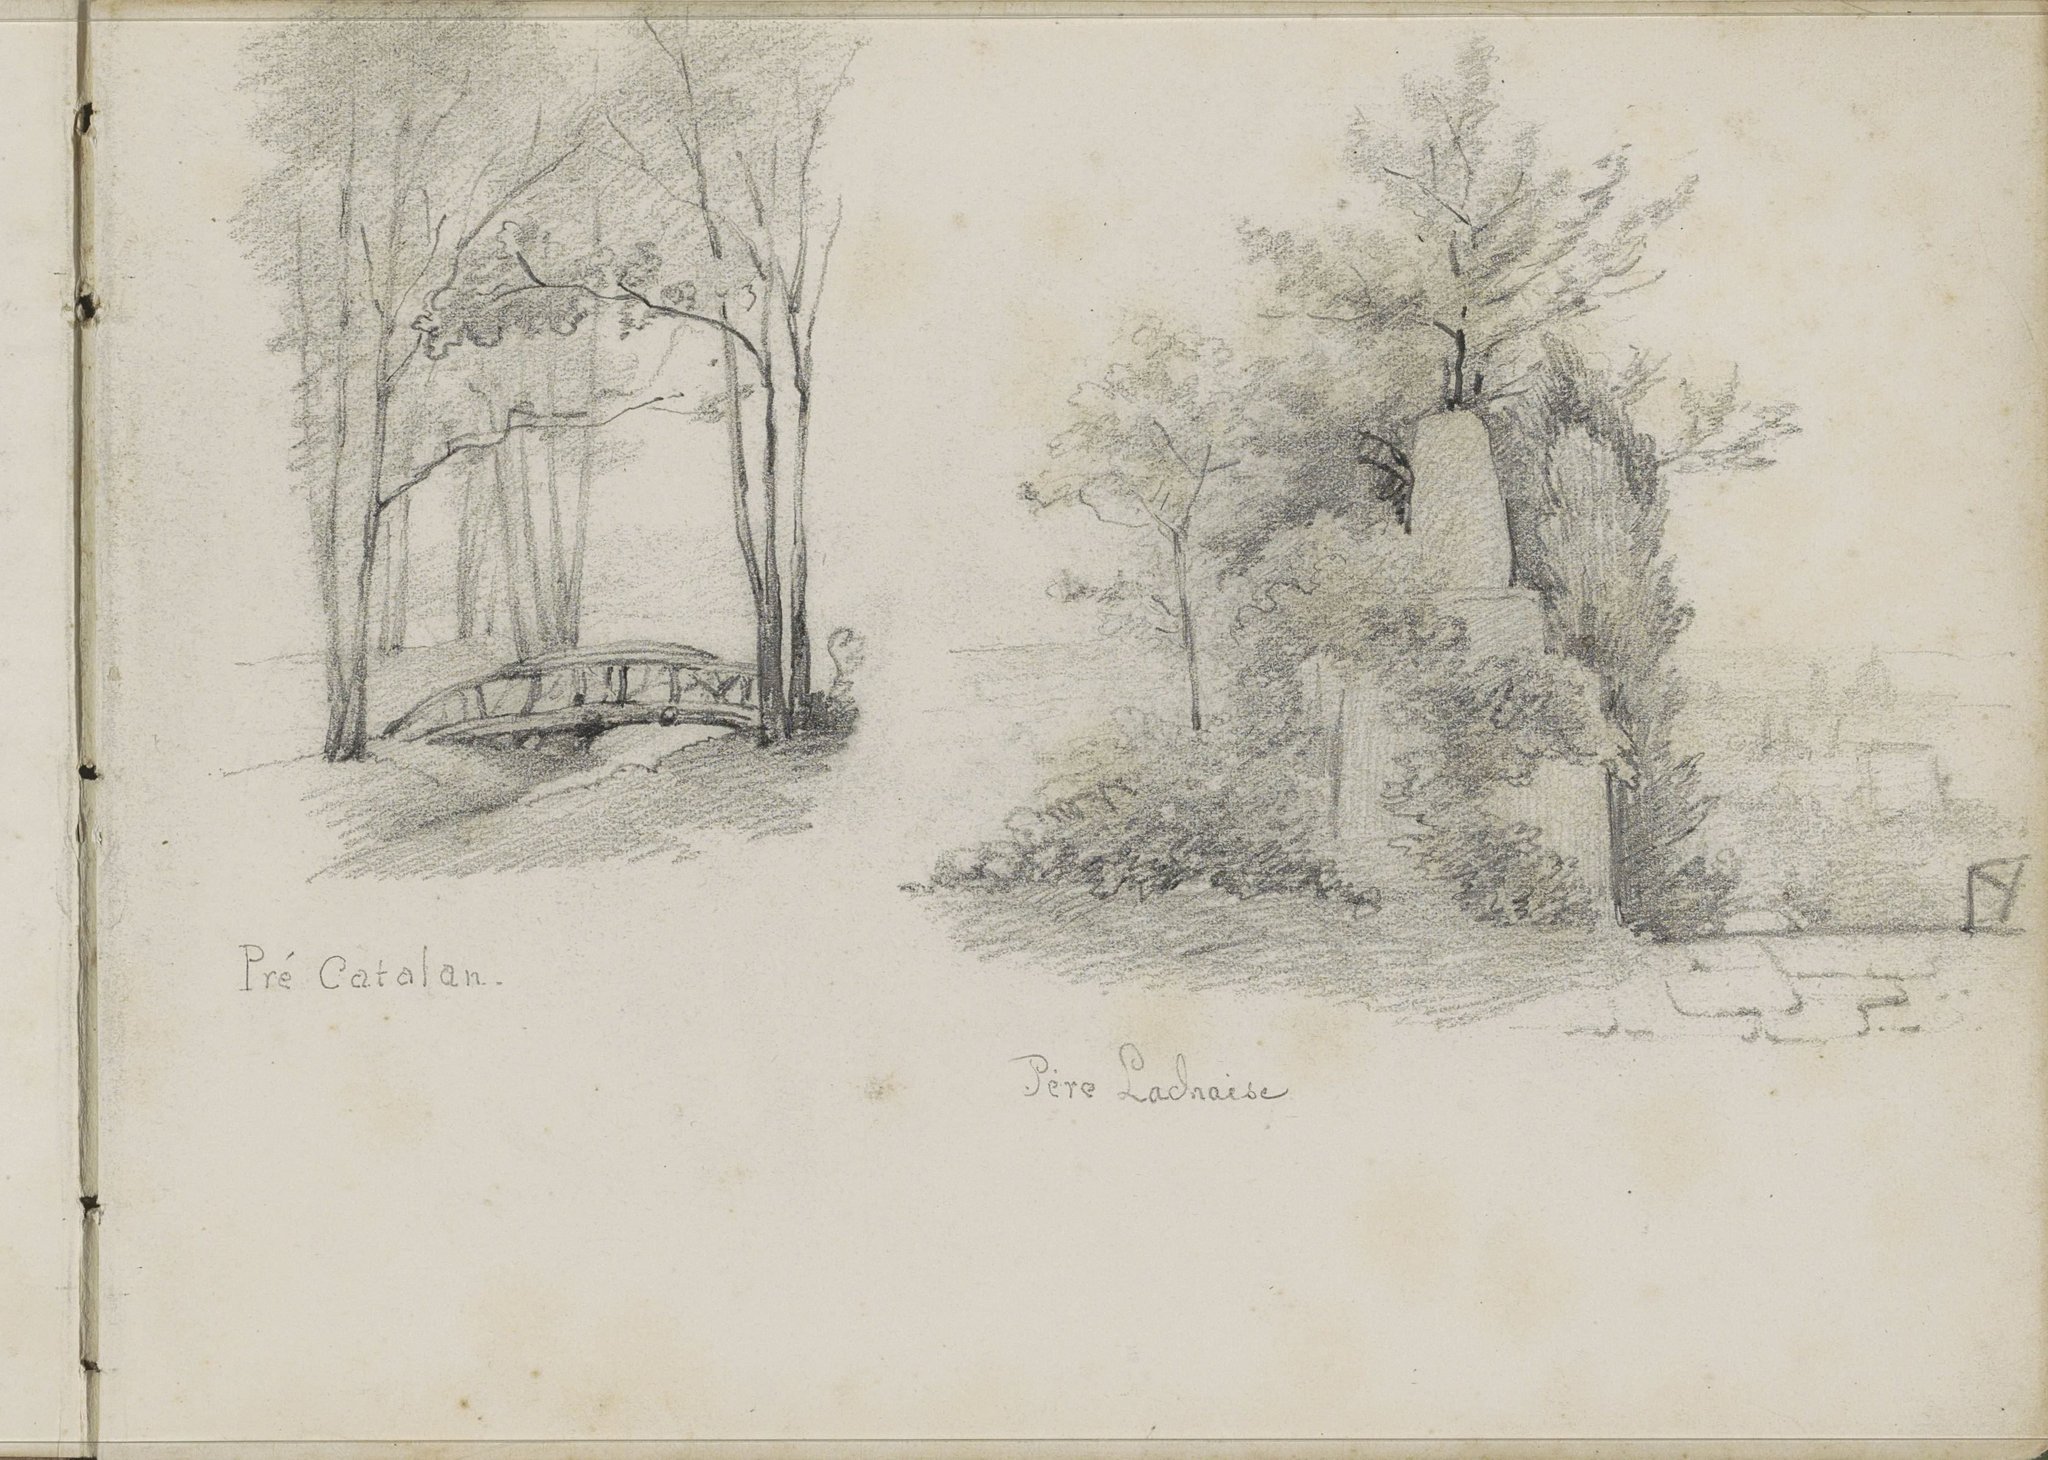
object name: sketchbook leaf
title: Brug bij Pré Catalan en een monument op begraafplaats Père-Lachaise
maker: gerrit postma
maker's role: draughtsman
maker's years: 1819-1894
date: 1858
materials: paper, pencil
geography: paris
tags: bridge, grave, tomb and other grave-forms and grave-markers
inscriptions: annotation: ‘Pré Catalan/ Pere Lachaise’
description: Blad 1 recto uit een schetsboek met 52 bladen.